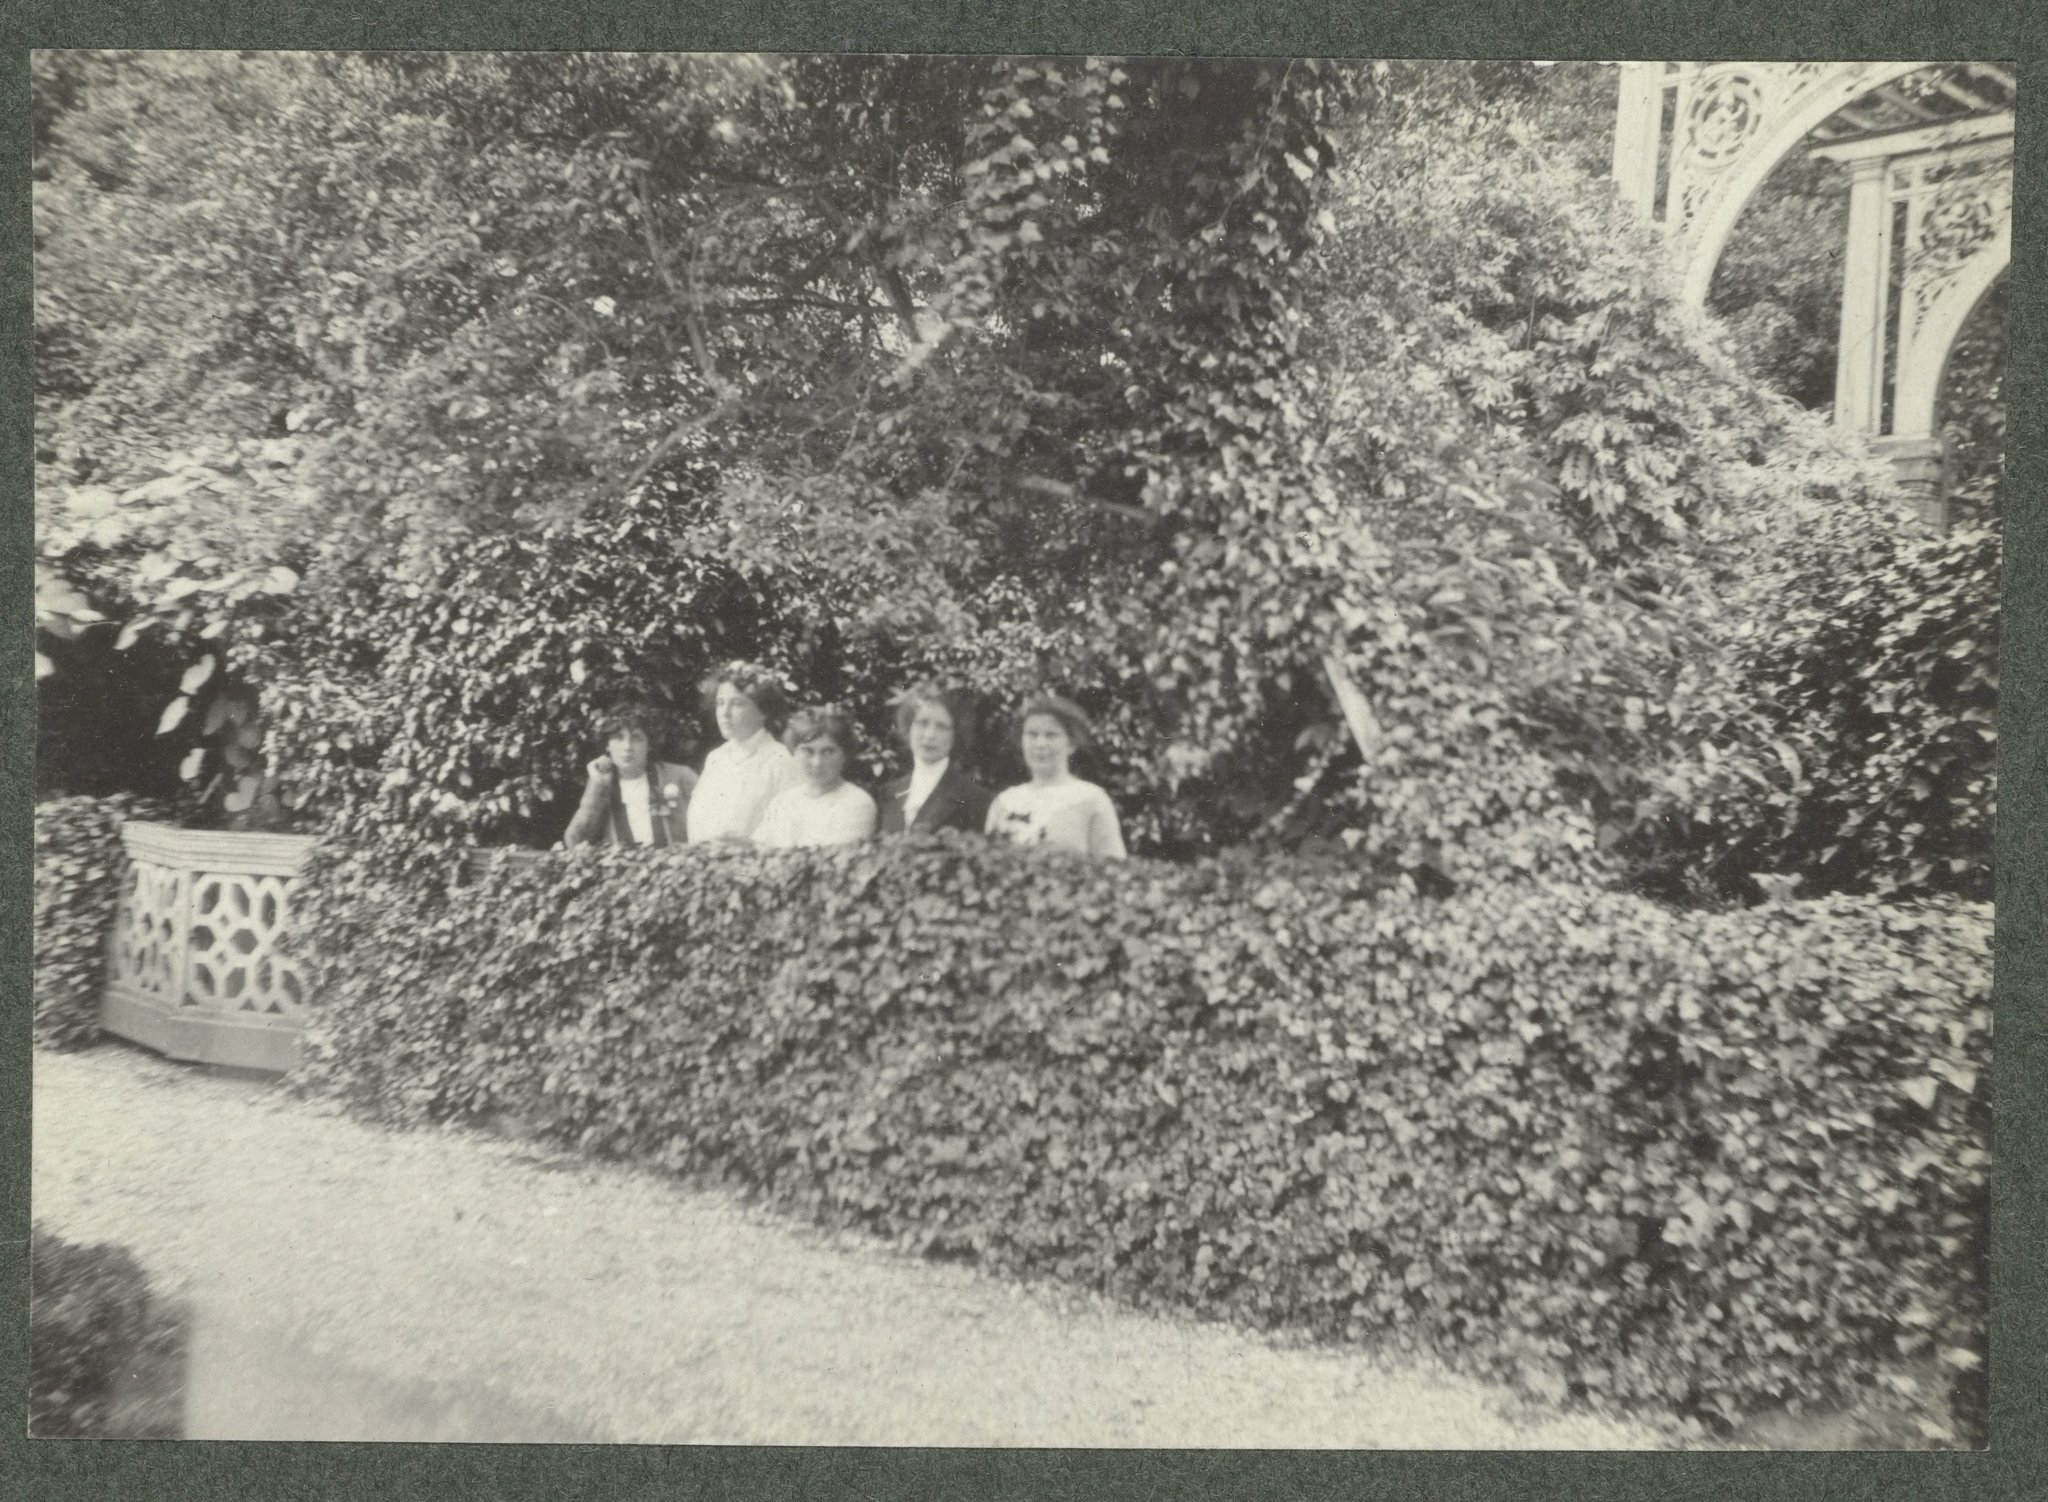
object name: photograph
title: Vijf vrouwen op een rij achter een heg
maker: geldolph adriaan kessler (dolph)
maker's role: fotograaf, industrieel, voetballer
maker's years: 1884-1945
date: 1913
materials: paper, photographic support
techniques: photography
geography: netherlands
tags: huize de paauw